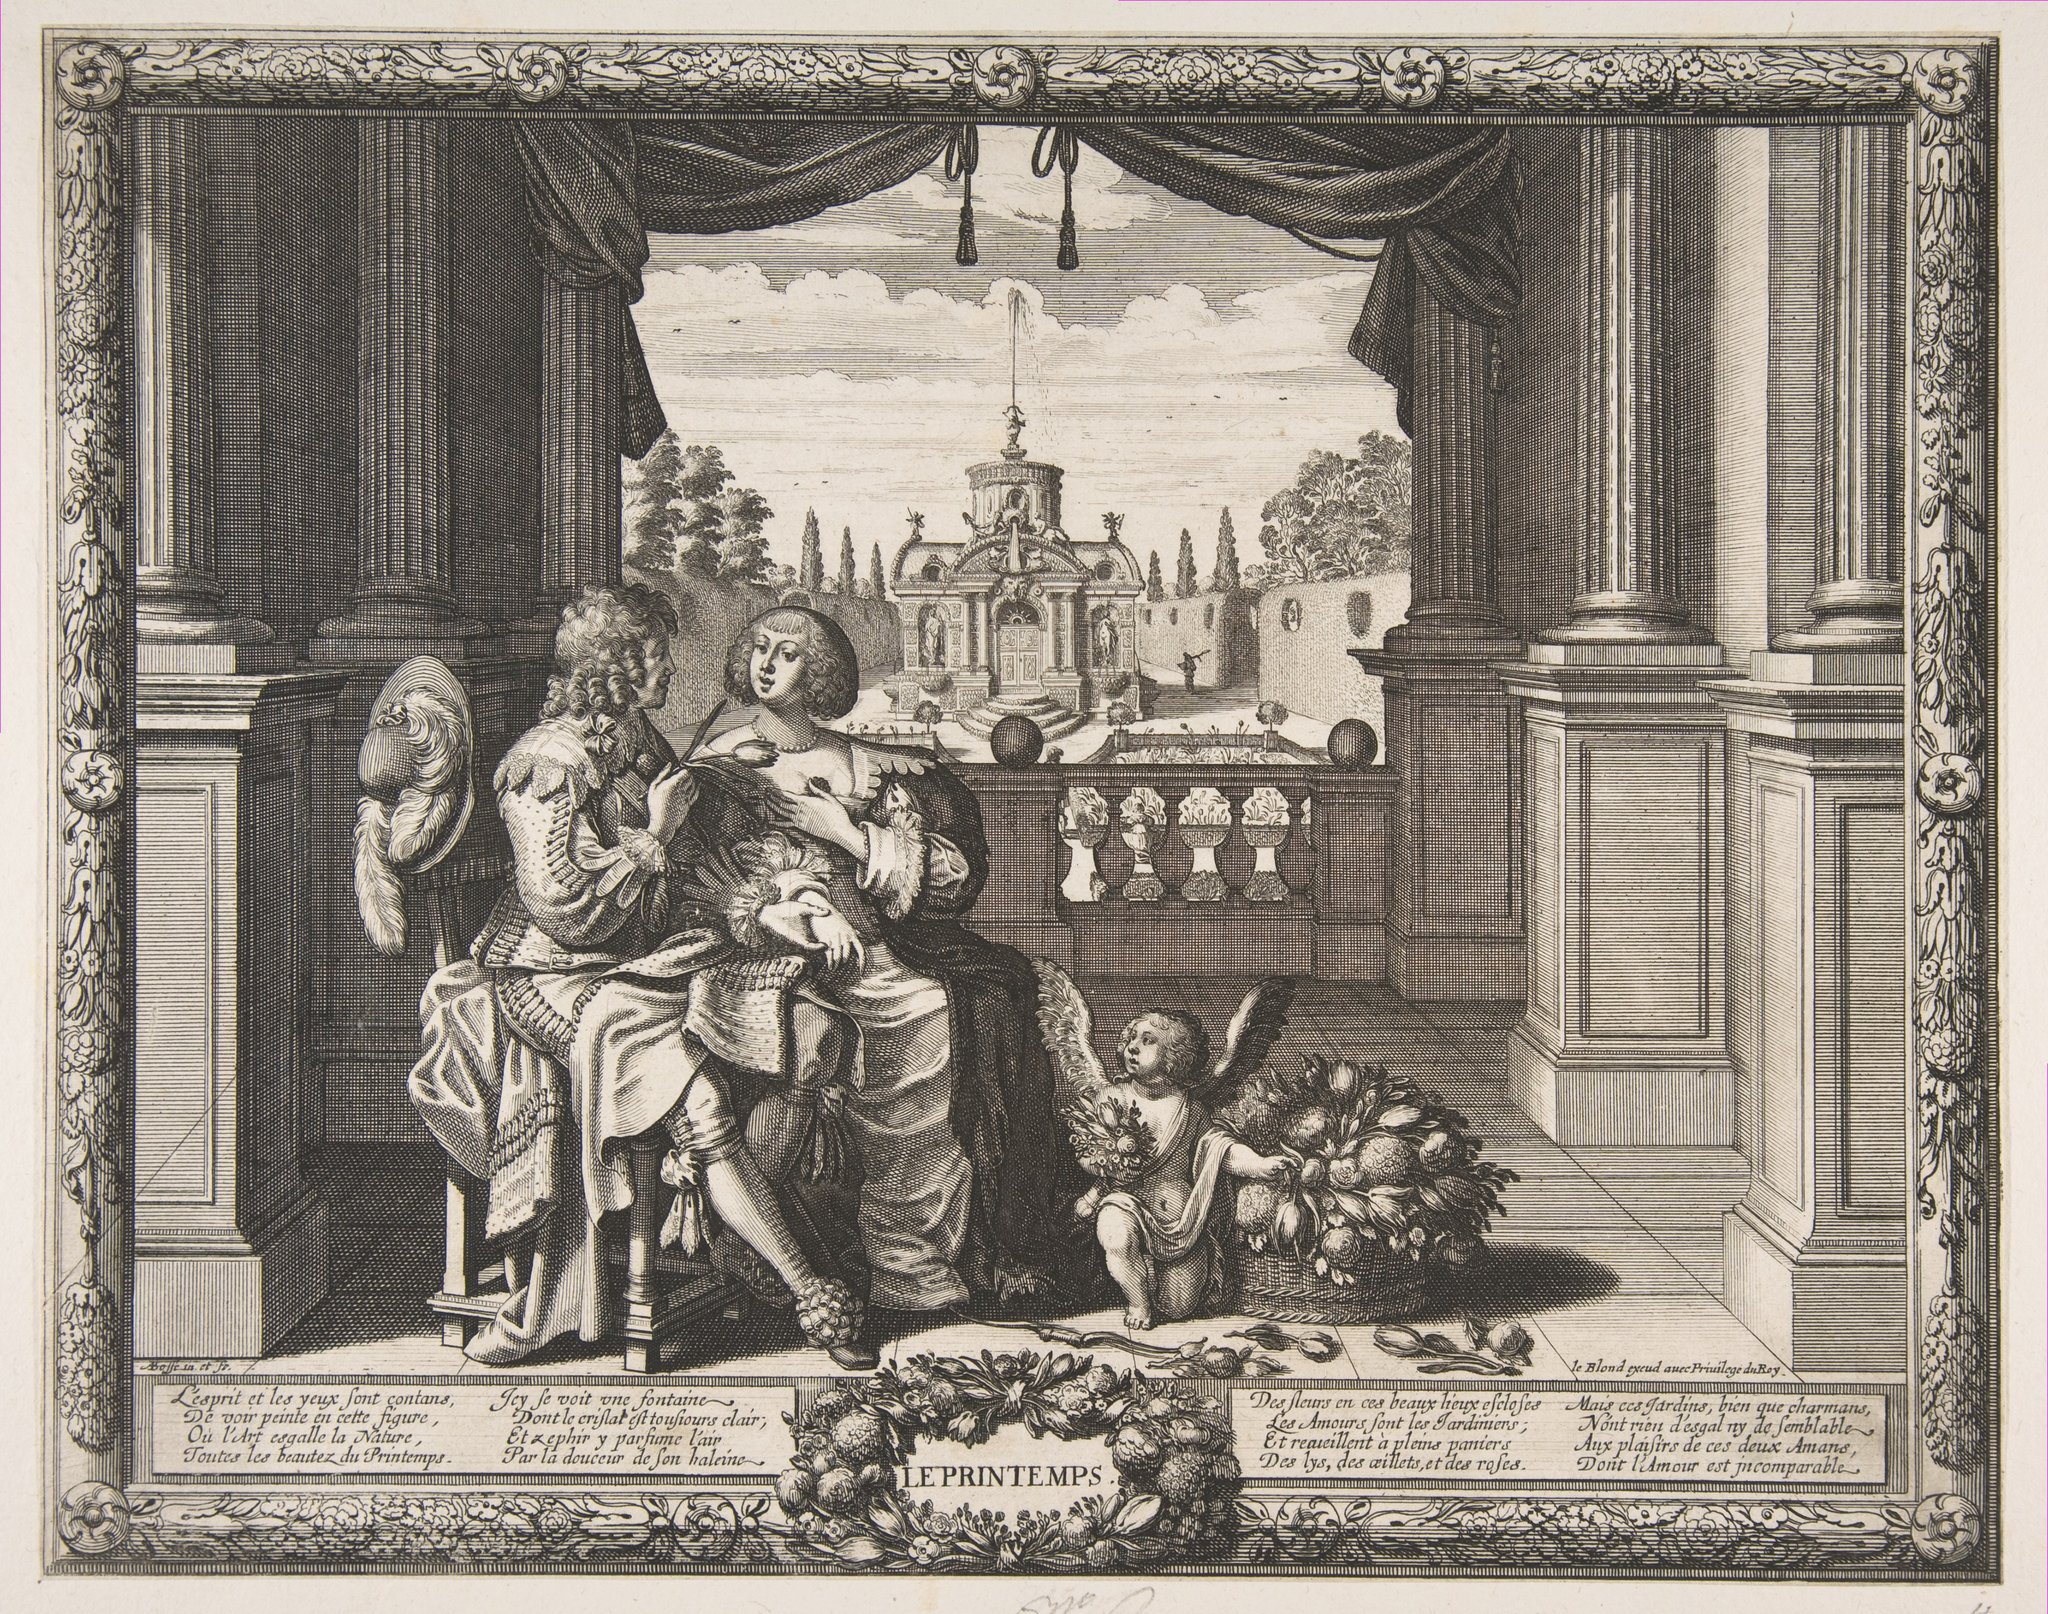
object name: print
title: Spring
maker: abraham bosse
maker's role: artist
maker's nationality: french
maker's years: 1602-1676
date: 1635-1637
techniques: etching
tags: buildings,men,women